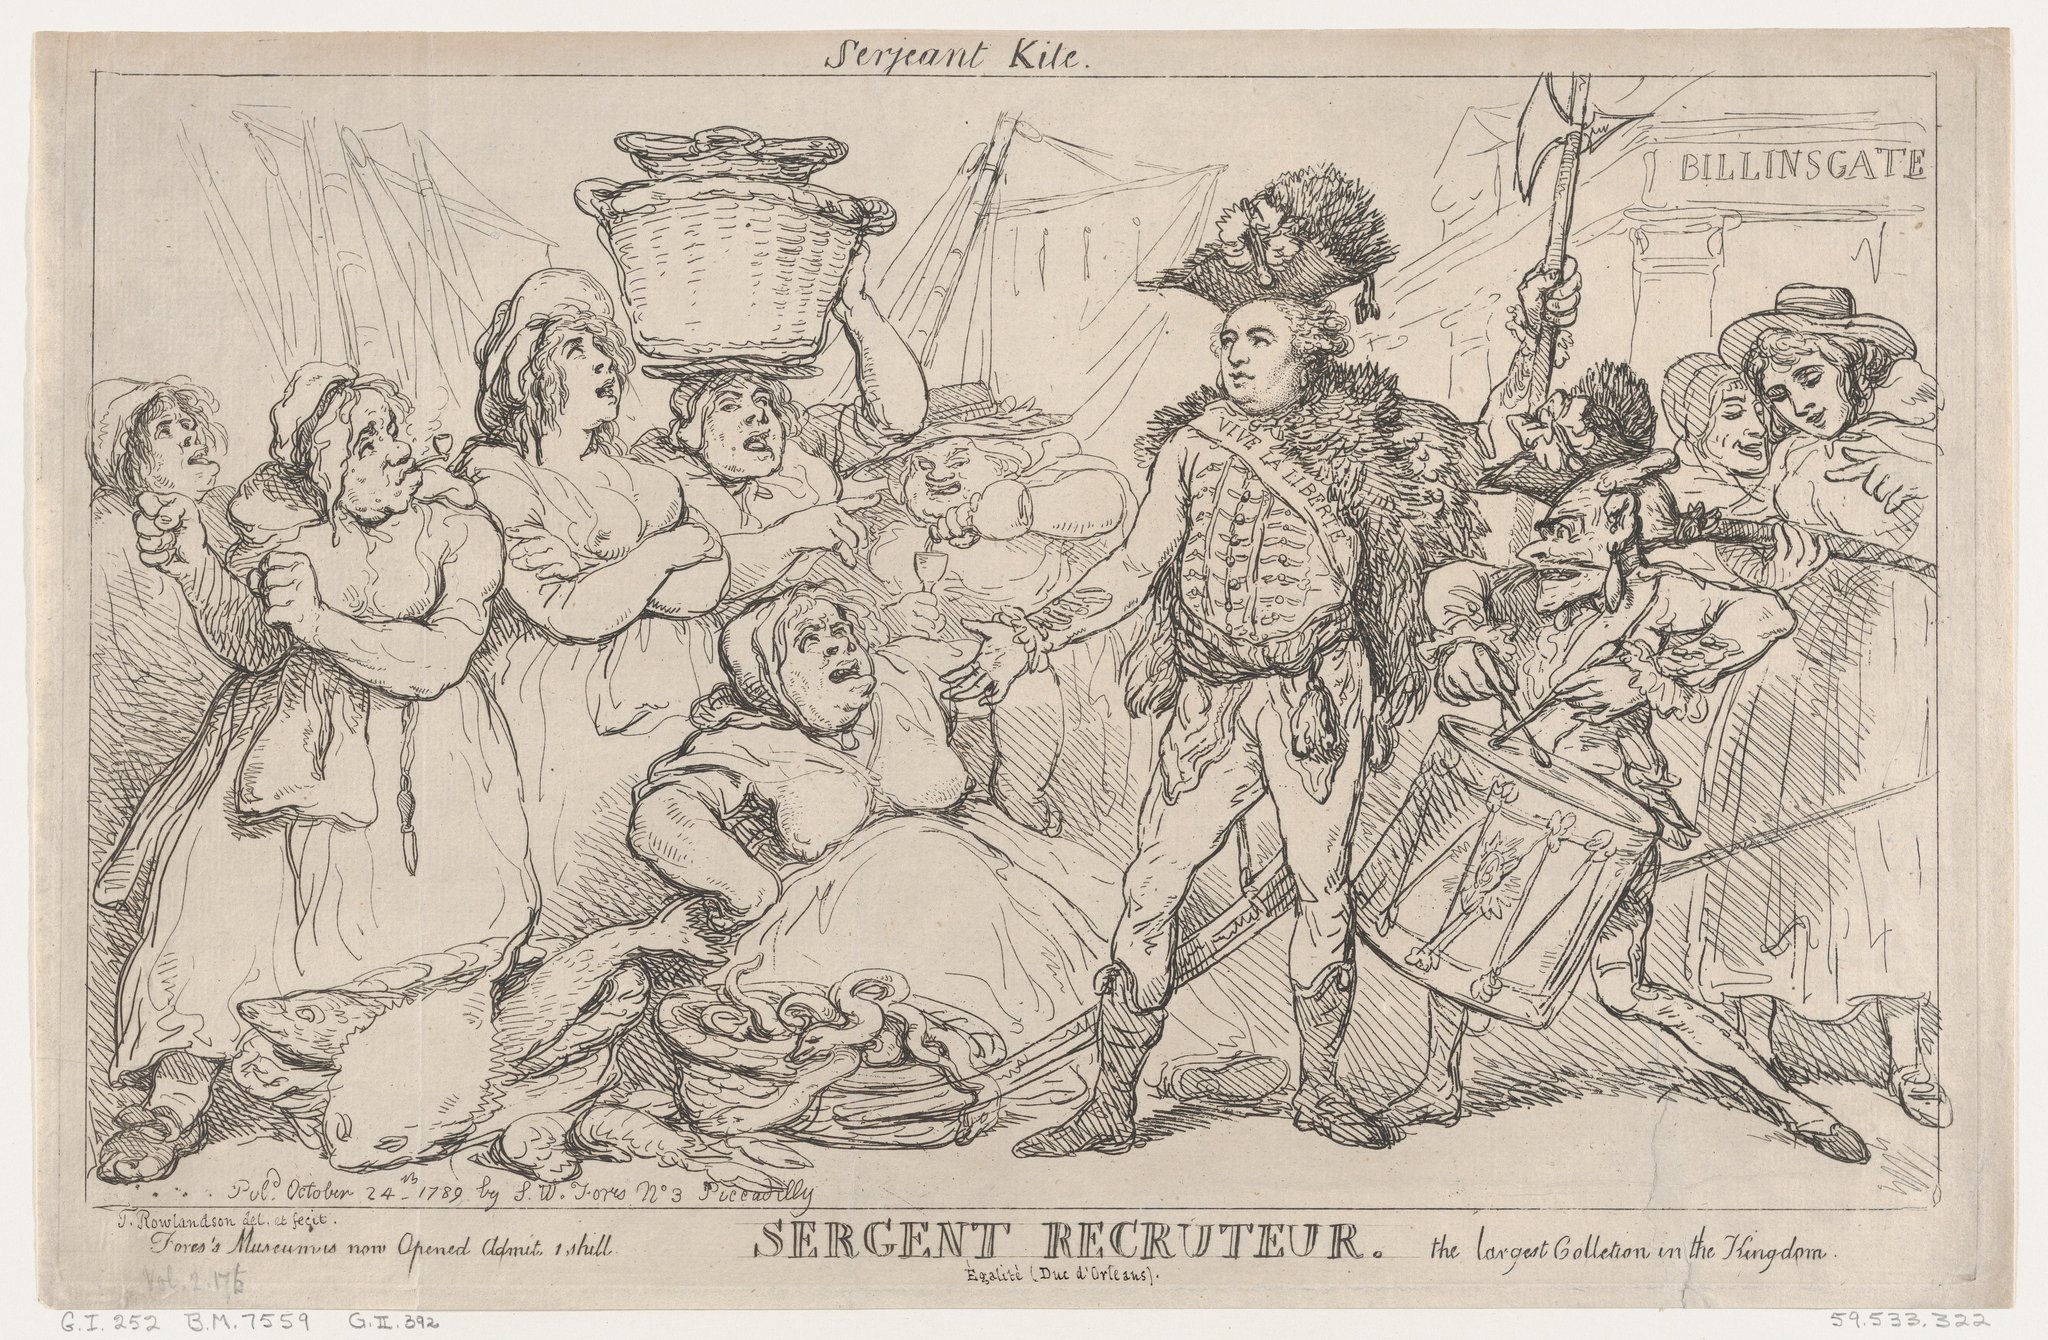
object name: print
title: Sergent Recruteur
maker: thomas rowlandson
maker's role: artist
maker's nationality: british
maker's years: 1757-1827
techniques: etching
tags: men,women,drums,fish